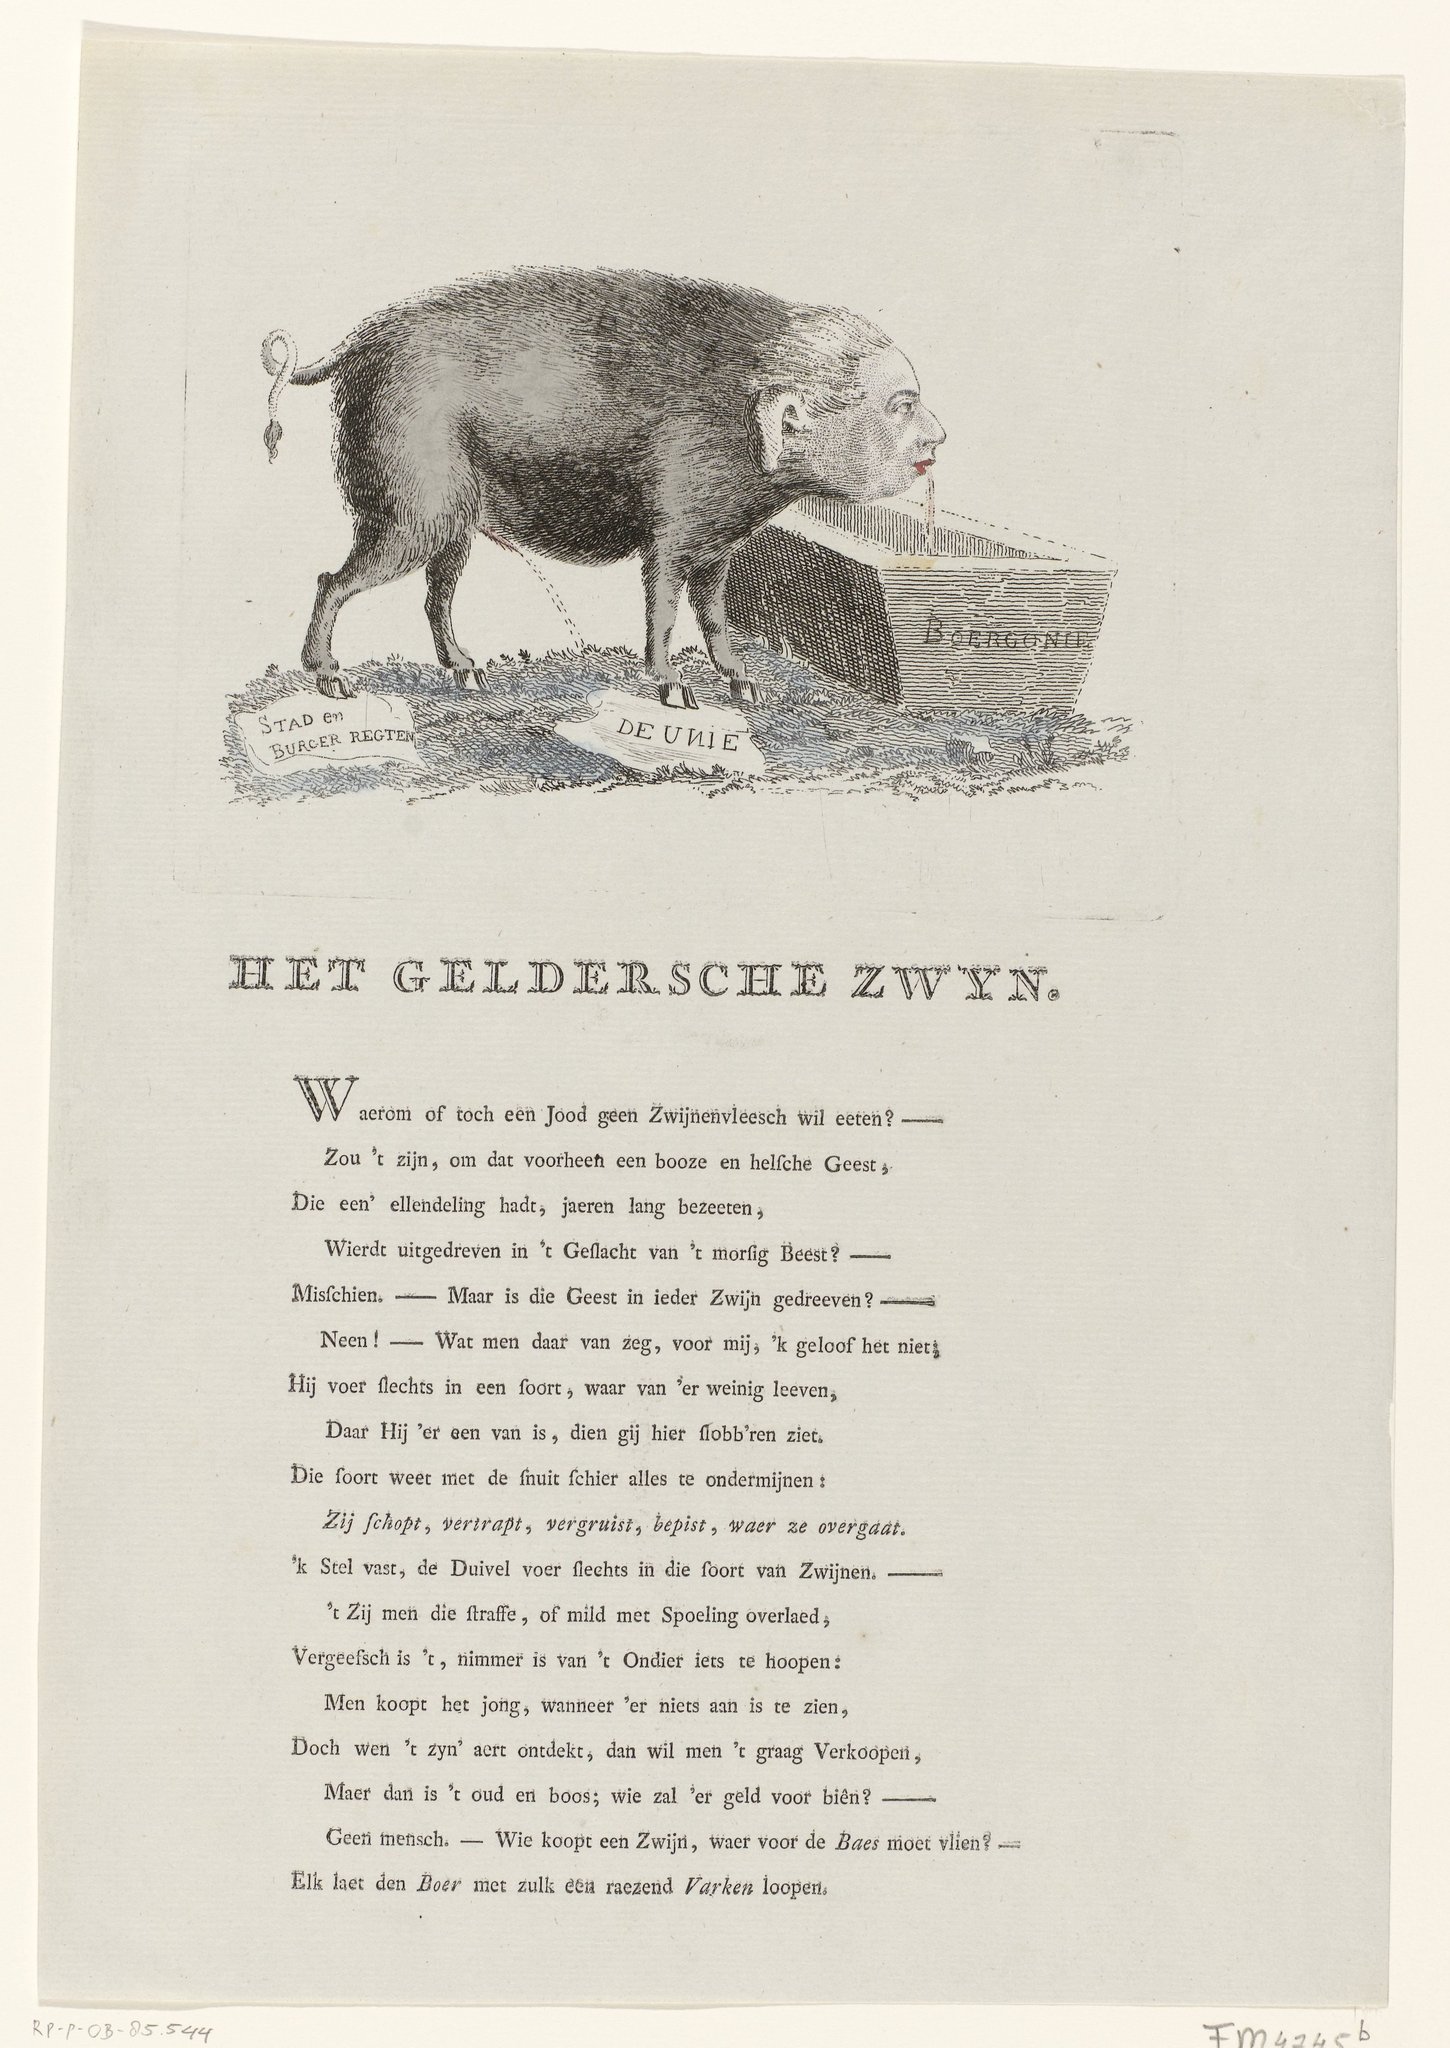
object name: cartoon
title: Spotprent op Willem V, 1786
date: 1786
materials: paper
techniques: etching, hand coloring, letterpress printing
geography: northern netherlands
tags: the hague, william v (prince of orange), boar (male pig), monsters ~ mammals, urination, political caricatures and satires, patriots (1780-1795)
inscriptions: collector's mark: Lugt 2228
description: Spotprent op stadhouder Willem V, 1786. De prins afgebeeld als een zwijn dat drinkt uit een bak met Bourgogne wijn en tegelijkertijd spuugt, de stads- en burgerrechten vertreedt en urineert op de Unie. Op het blad onder de plaat een vers van 18 regels.